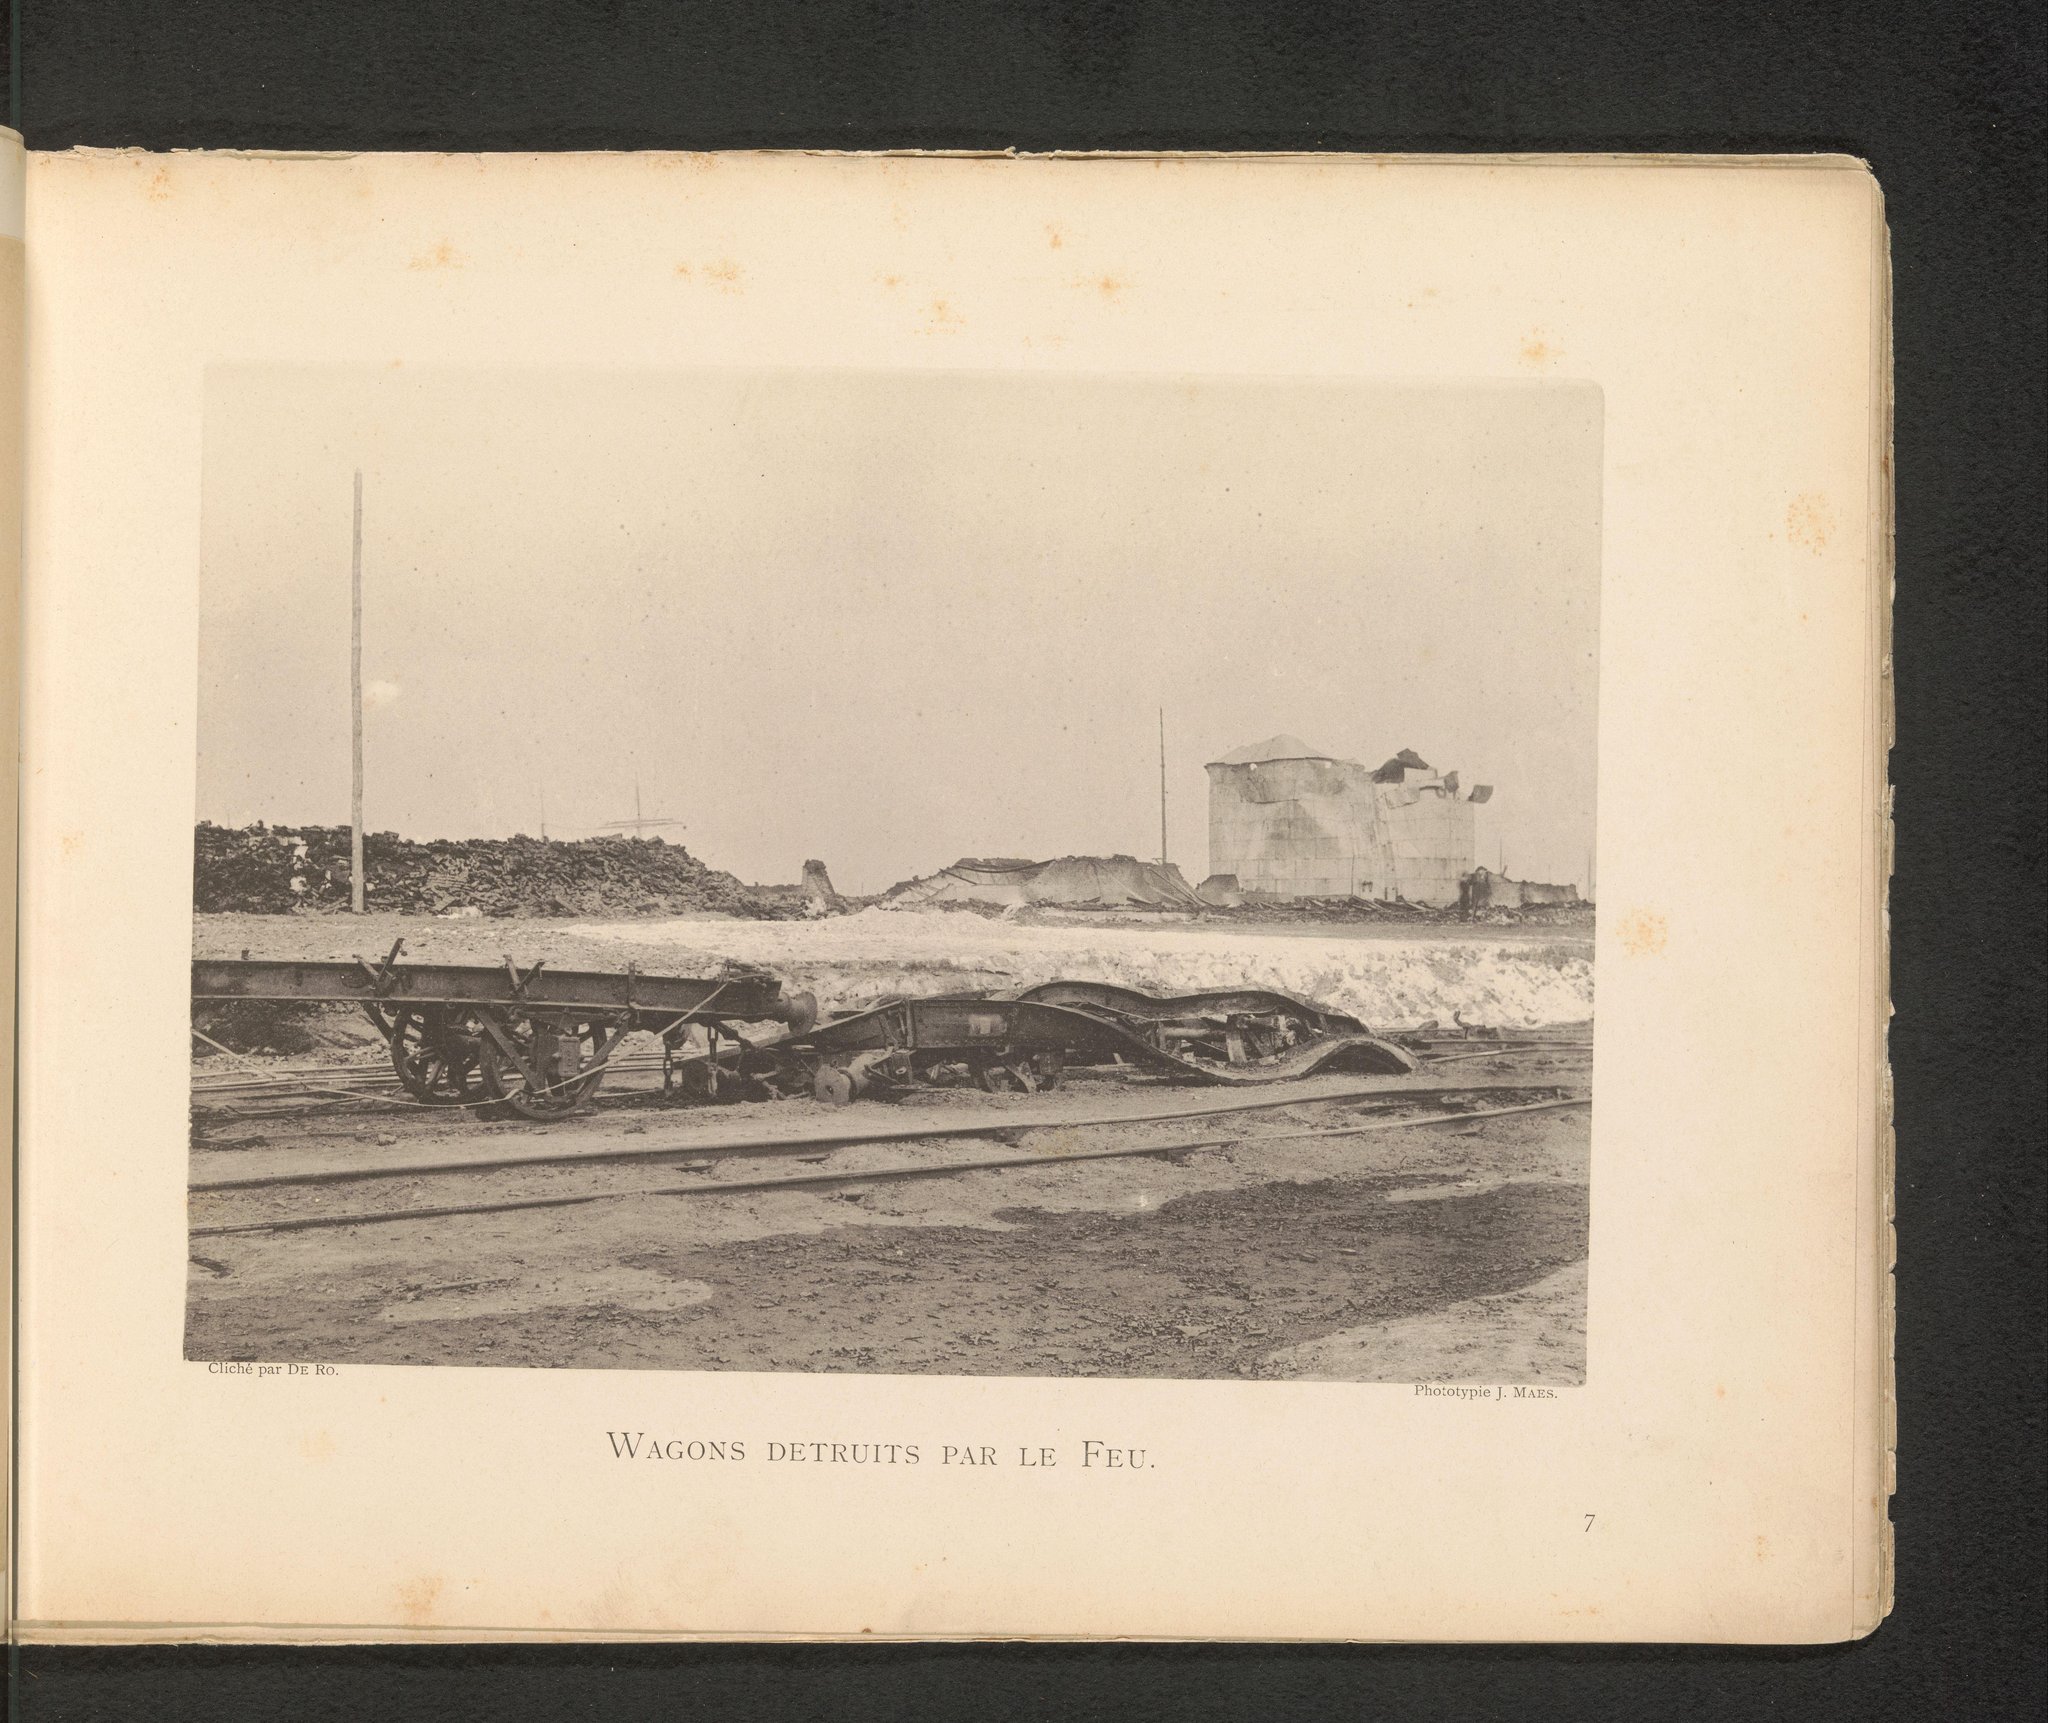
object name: page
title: Treinwagon die is verwoest door de ontploffing van een munitiefabriek in Oosterweel bij Antwerpen op 6 september 1889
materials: paper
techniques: photograph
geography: oosterweel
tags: railway wagon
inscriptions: number: ‘7’